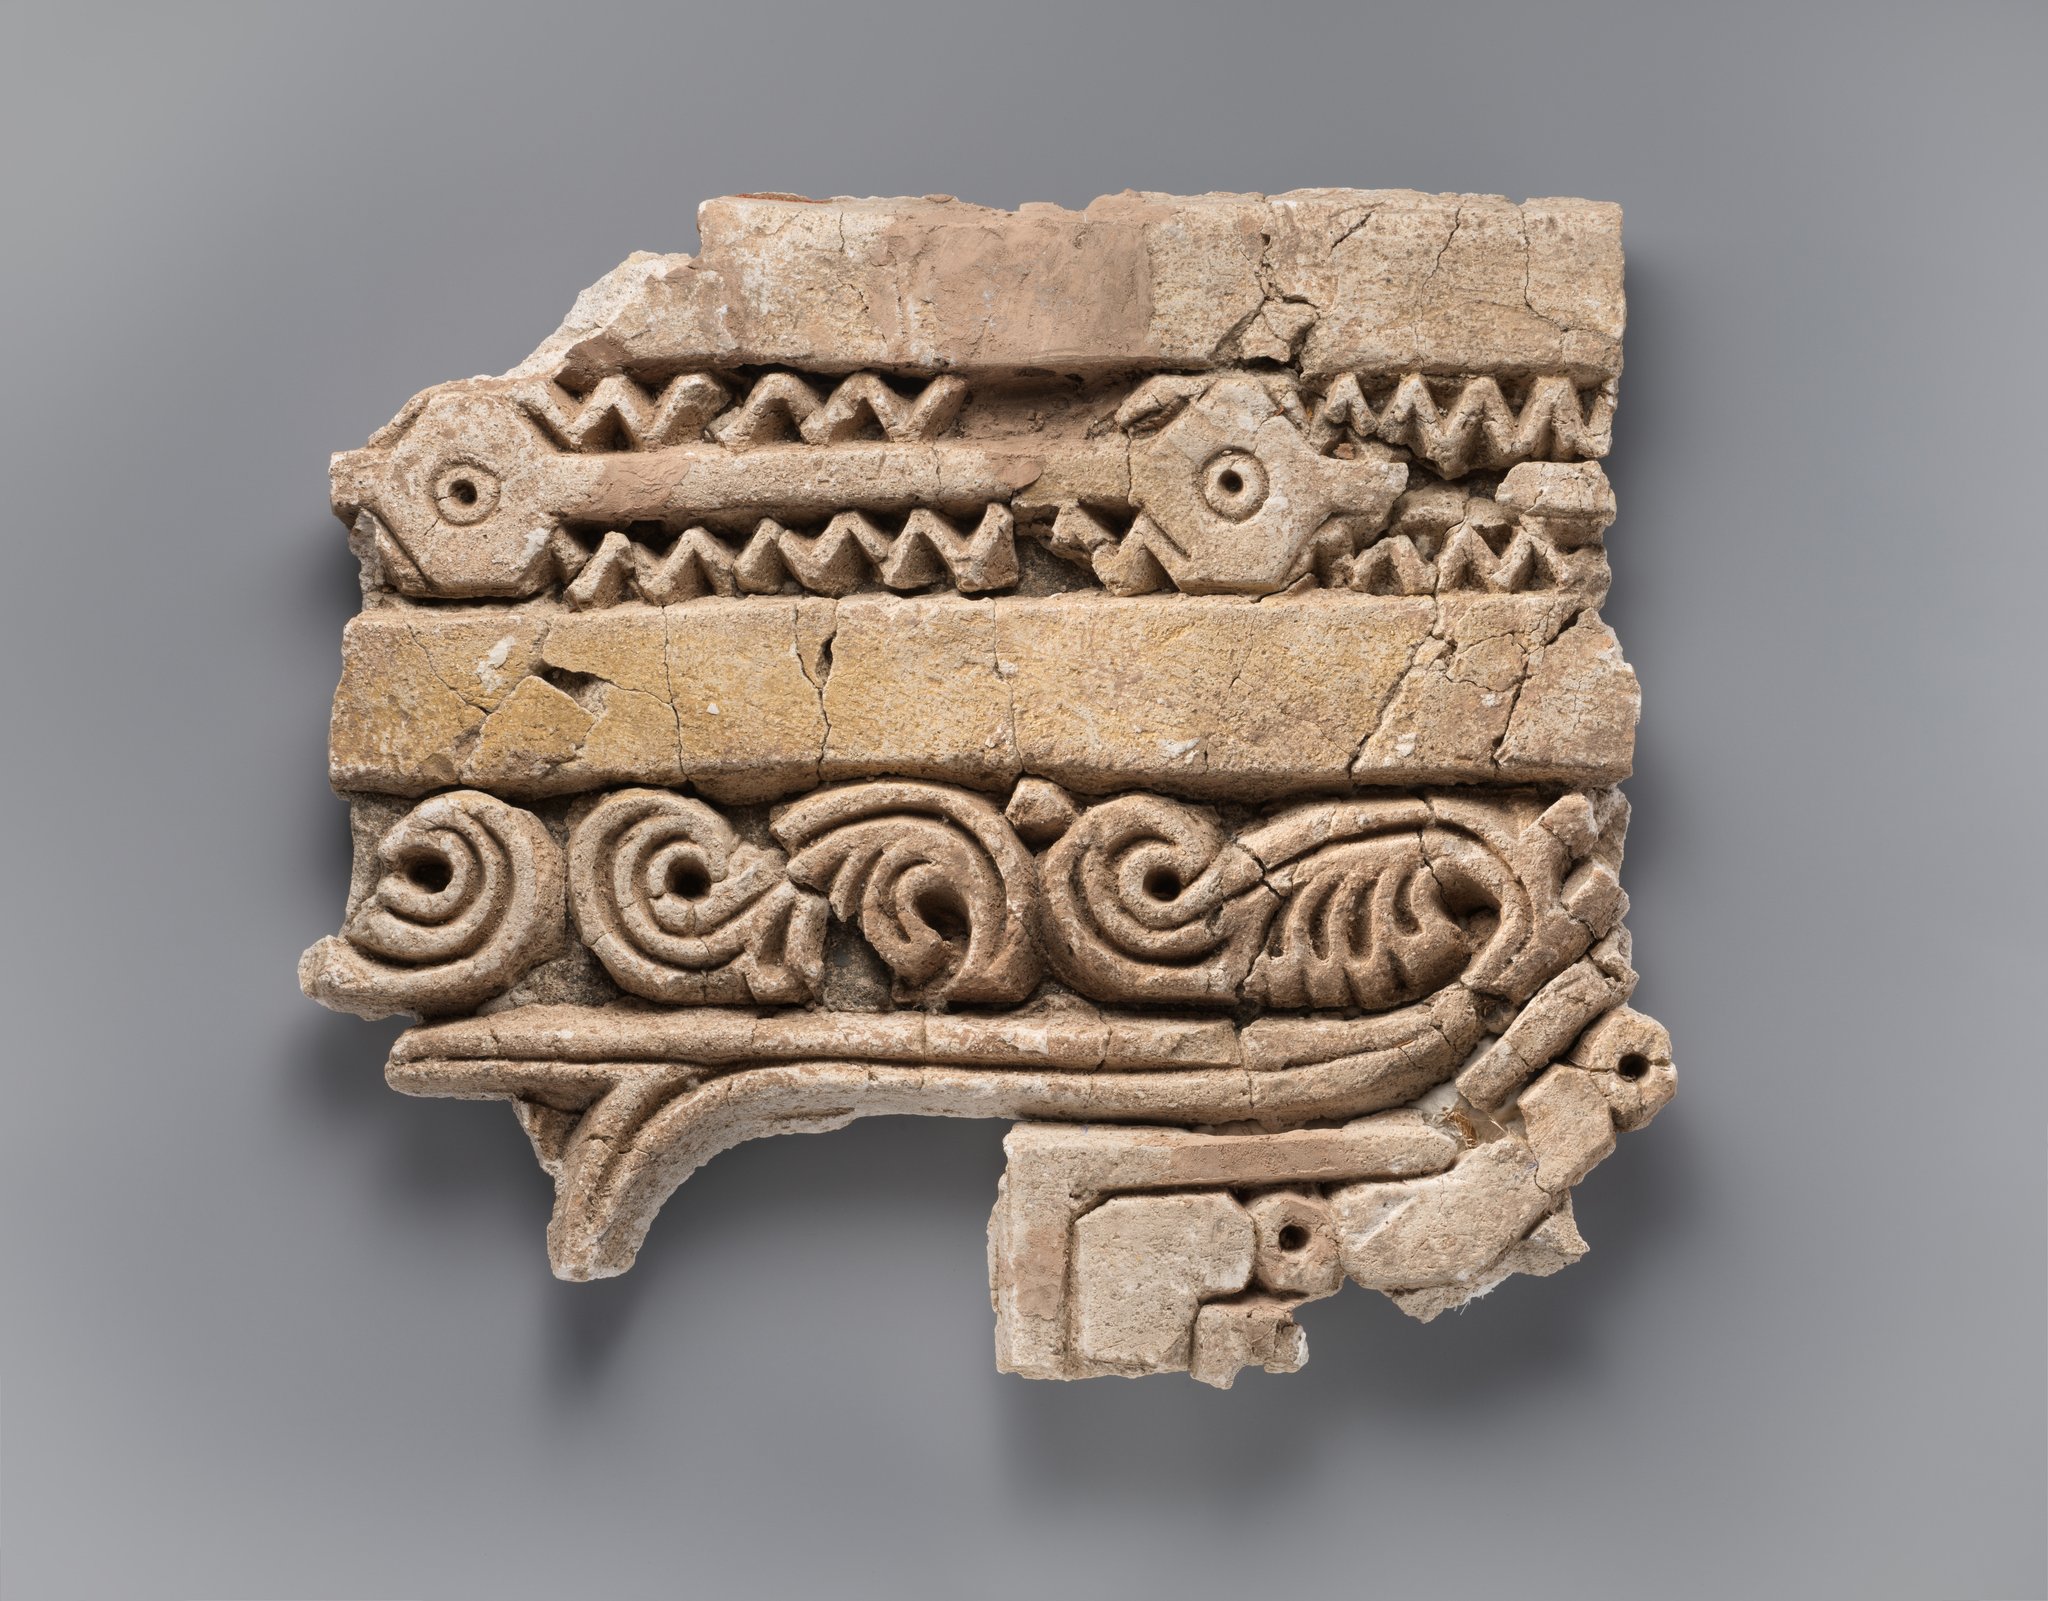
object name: fragment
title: Fragment of a Carved Panel with Stars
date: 701-1200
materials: plaster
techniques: carving, painting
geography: iran